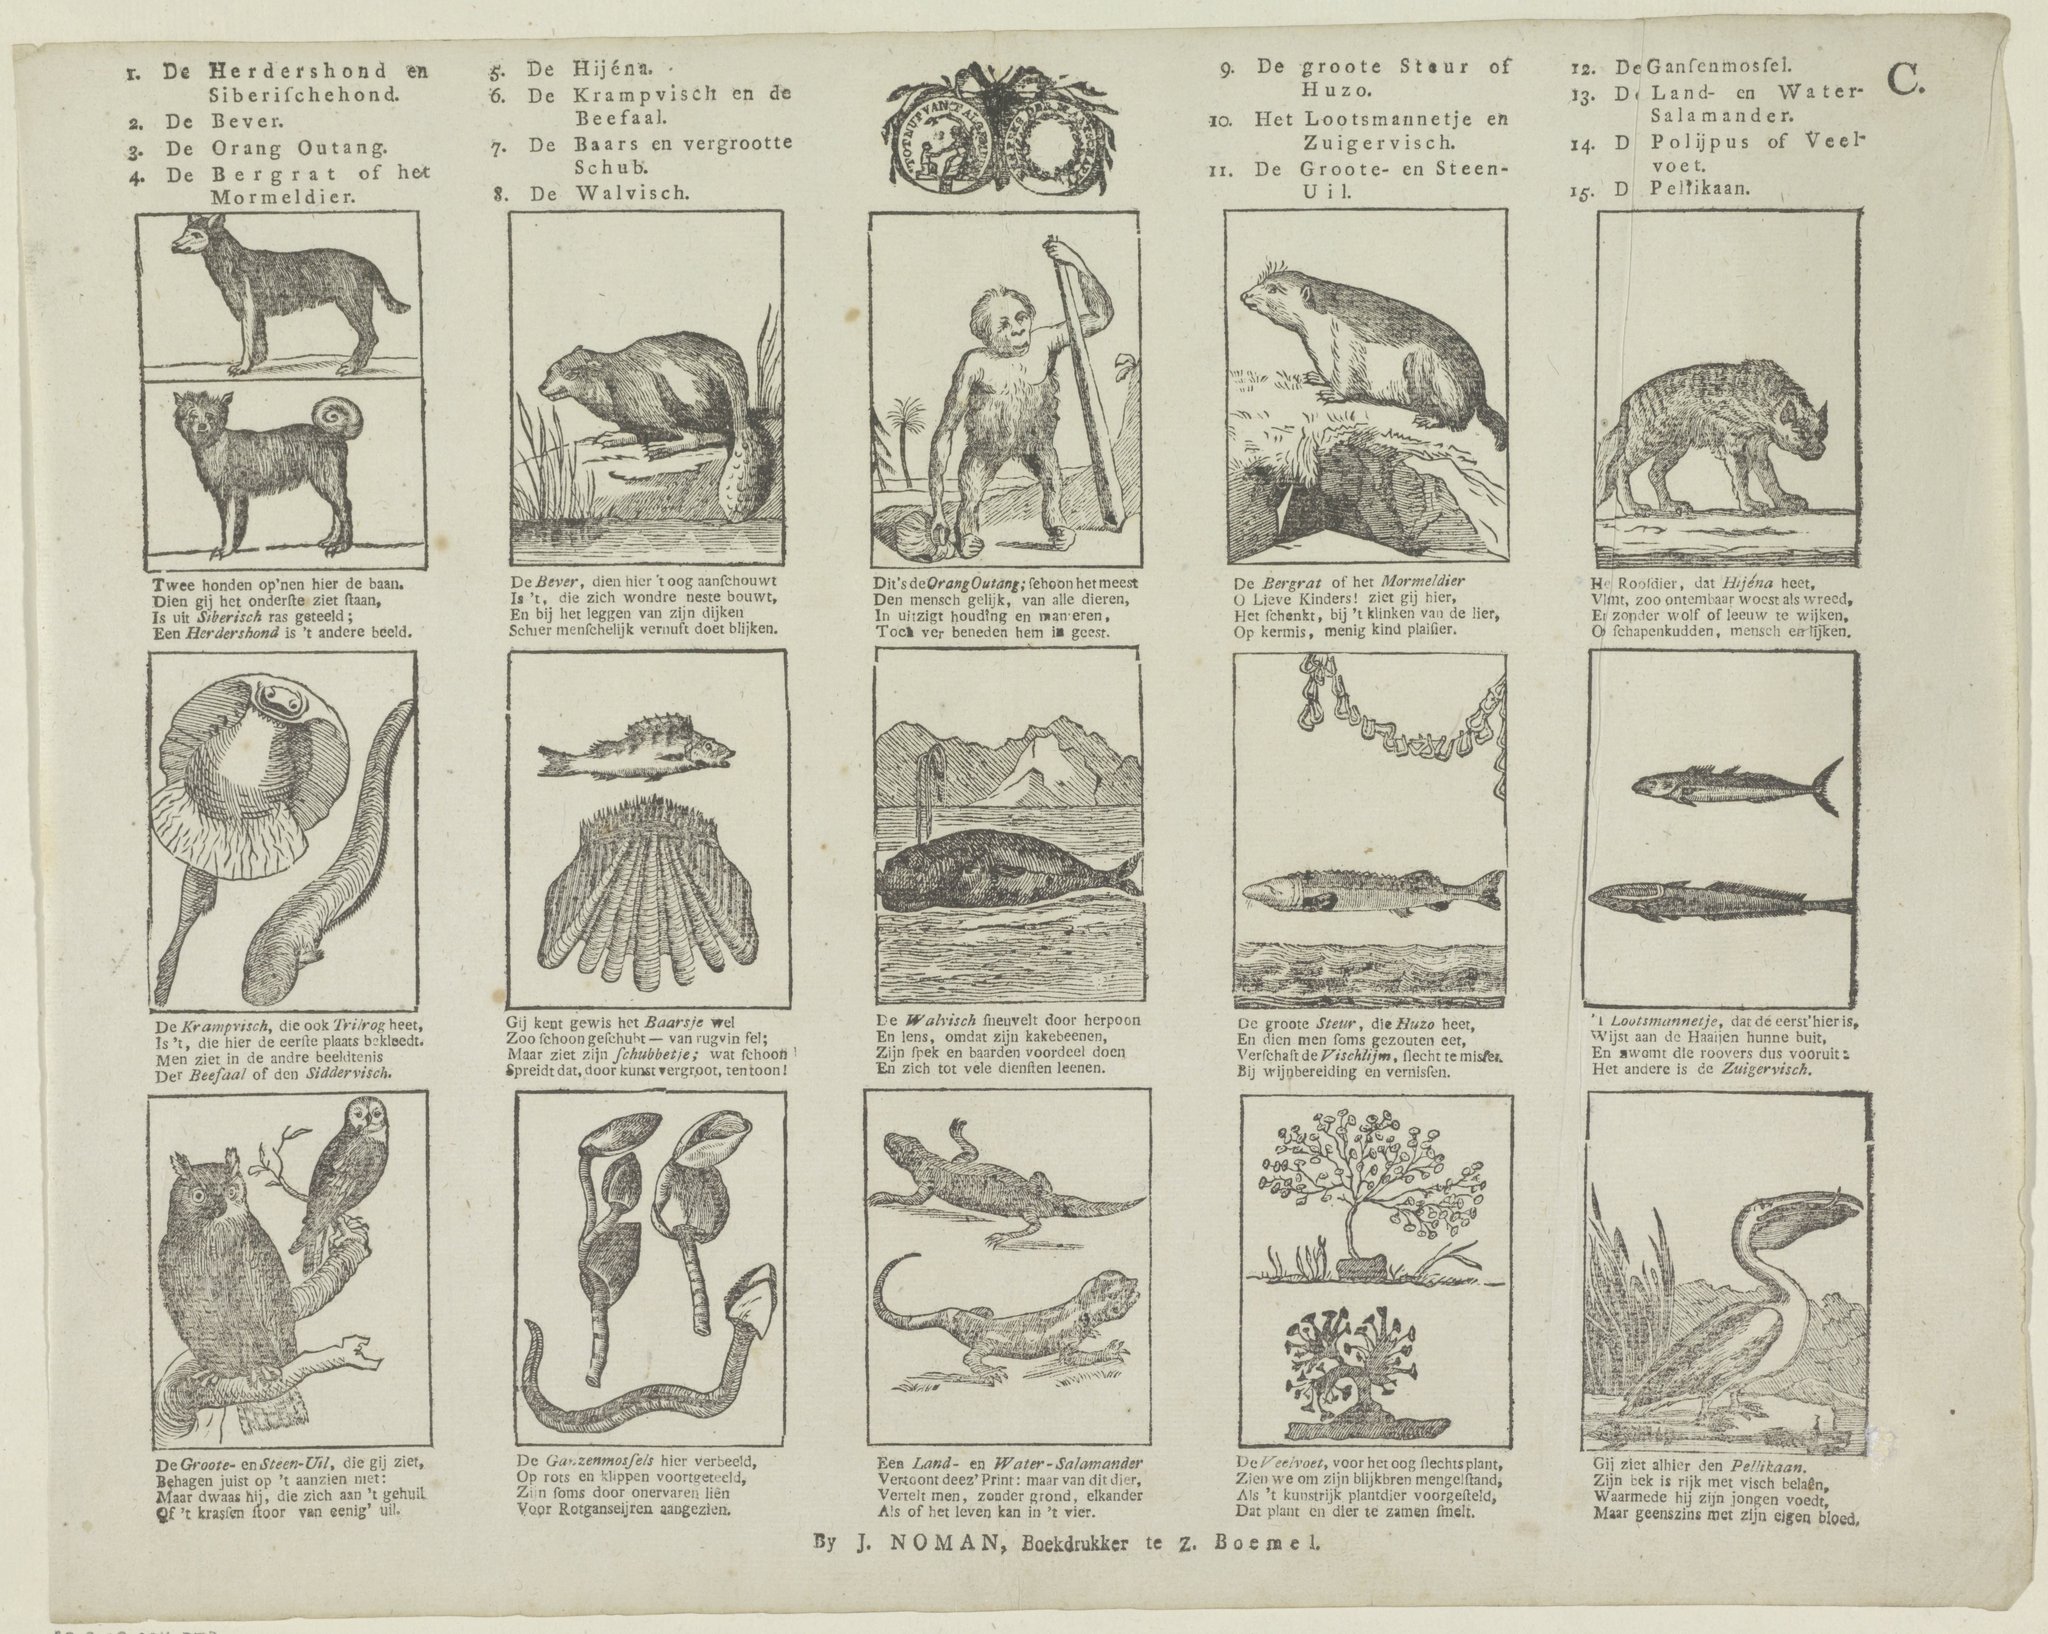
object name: print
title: Dieren en planten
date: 1806-1830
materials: paper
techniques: letterpress printing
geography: zaltbommel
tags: plants; vegetation, animals, monkeys, apes, fishes, owls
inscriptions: collector's mark: Lugt 2760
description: Blad met 15 voorstellingen van dieren en planten. Onder elke afbeelding een vierregelig vers. Boven een verklarende lijst met nummers. Midden boven het zegel van de Maatschappij tot Nut van 't Algemeen. Gemerkt rechtsboven: C.